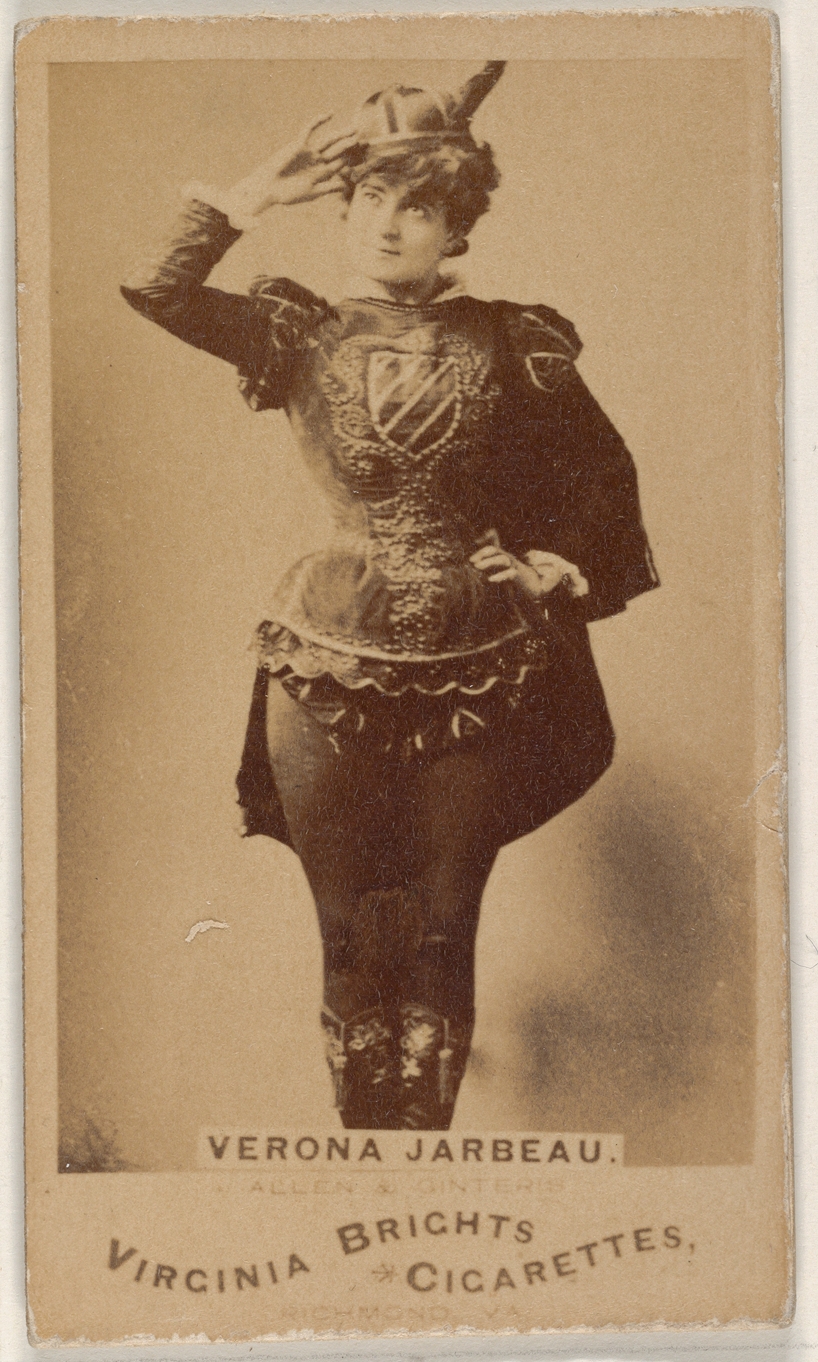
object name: photograph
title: Verona Jarbeau, from the Actors and Actresses series (N45, Type 1) for Virginia Brights Cigarettes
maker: allen & ginter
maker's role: publisher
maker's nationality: american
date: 1888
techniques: albumen silver print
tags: portraits,women,actresses